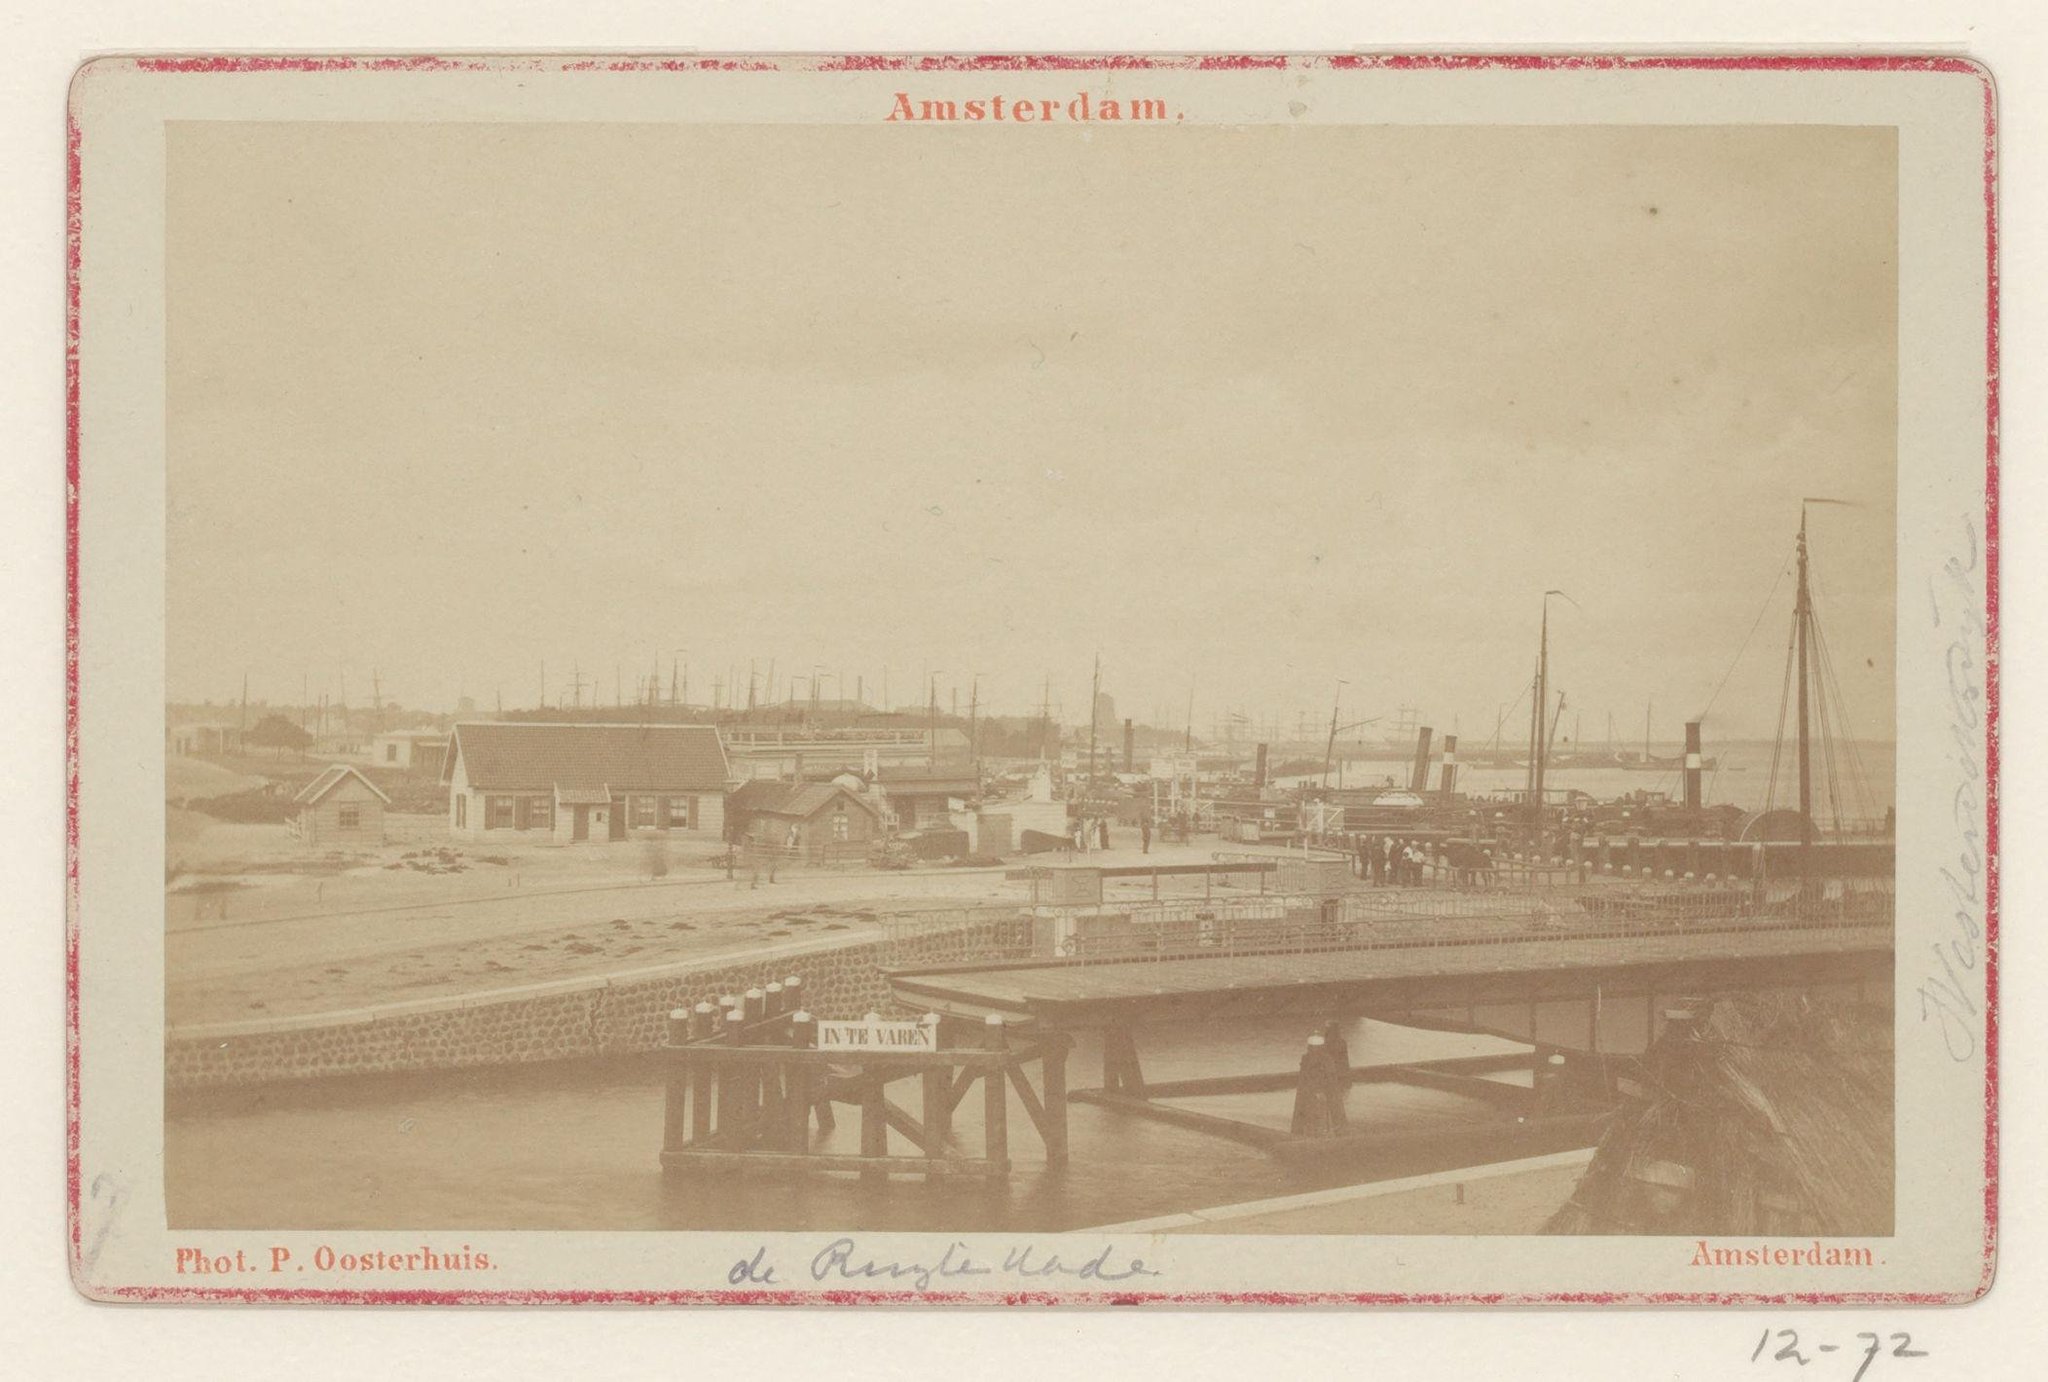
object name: cabinet photograph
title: Gezicht op de De Ruijterkade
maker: pieter oosterhuis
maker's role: draughtsman, print maker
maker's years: 1816-1885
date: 1880-1885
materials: cardboard, paper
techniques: albumen print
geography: amsterdam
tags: sailing-ship, sailing-boat, city-view in general; 'veduta', quay, steamship, motorship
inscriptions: inscription: ‘Aanlegplaats Stoombooten / Westerdoksdijk’, collector's mark: ‘12,72’ Lugt 1641b, inscription: ‘de Ruyterkade’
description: Onderwerpsrubriek binnen de Atlas Amsterdam: Rokin, Rotterdammersloot, Rozengang, Rozengracht, Rozenstraat, Rusland, Rustenburgerstraat, Ruysdaelkade, Ruysdaelstraat, Ruyterkade (de), Ruyterweg (Admiraal de).